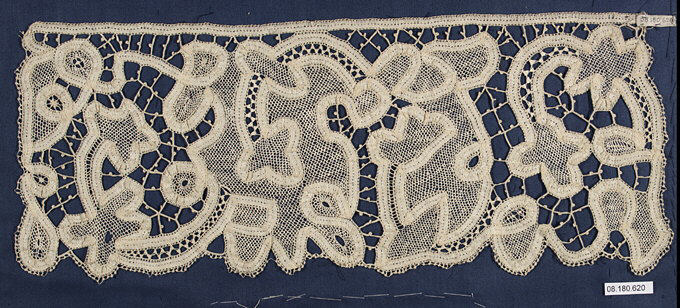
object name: fragment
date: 1601-1700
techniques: lace